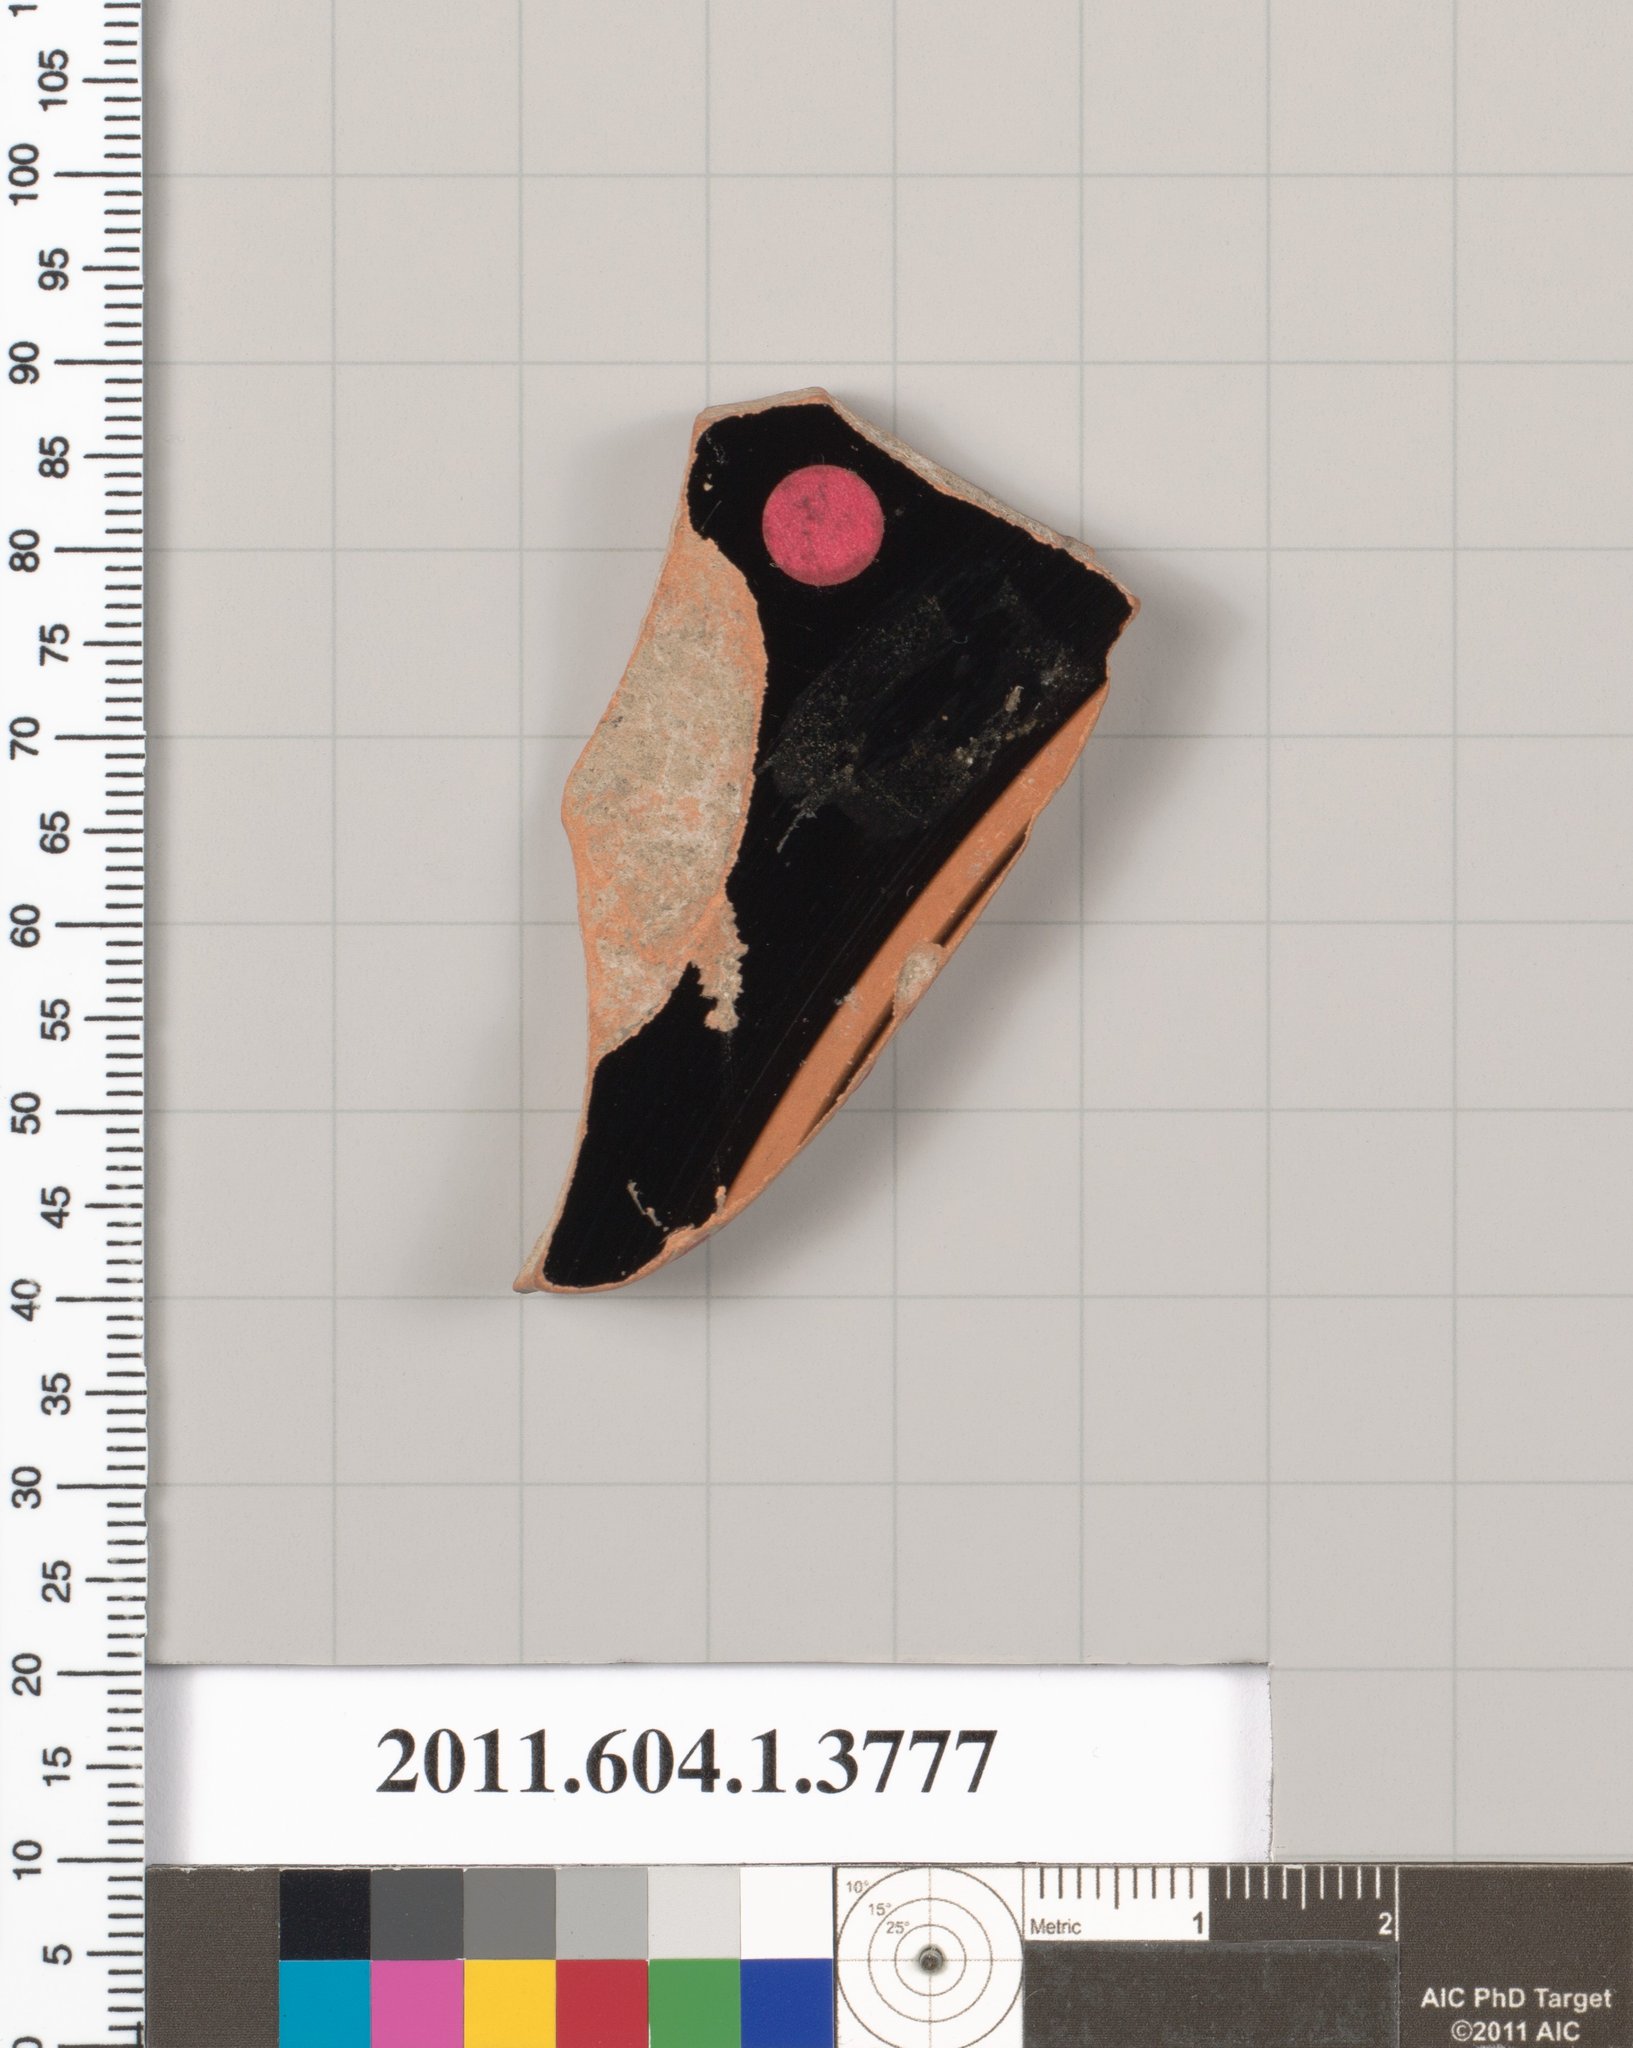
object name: kylix fragment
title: Terracotta fragment of a kylix (drinking cup)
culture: greek, attic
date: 520-500 BCE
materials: terracotta